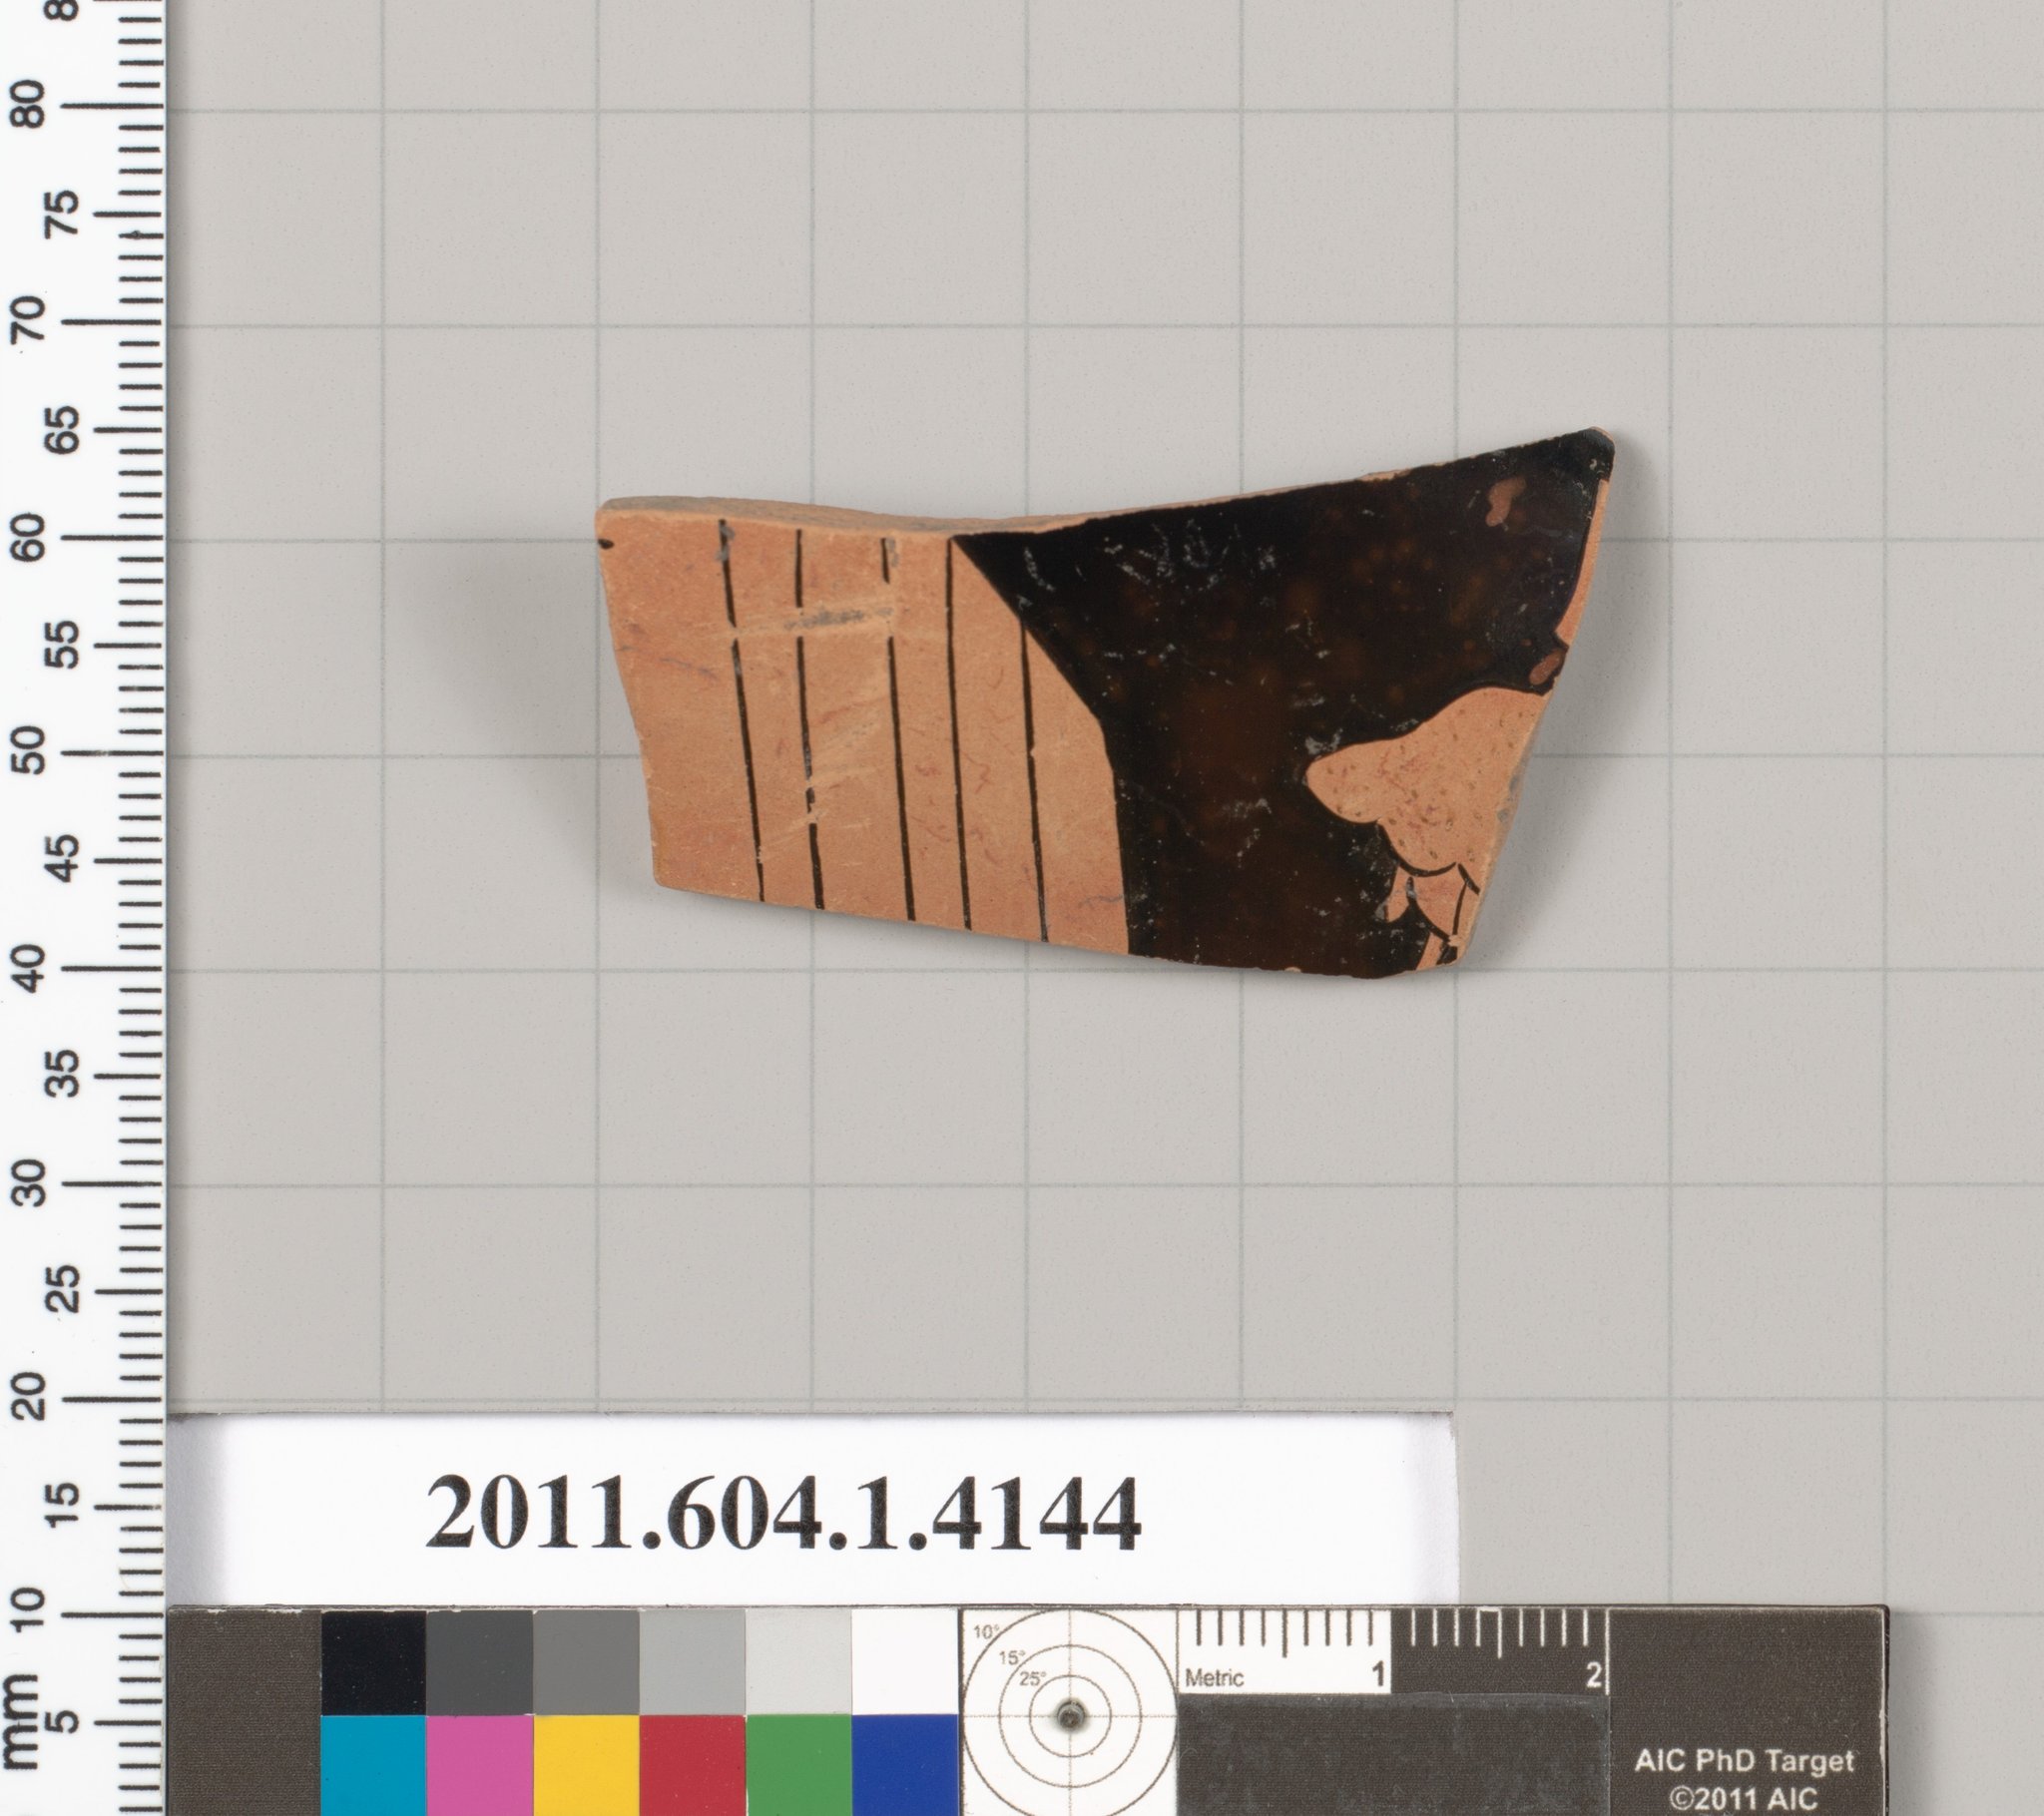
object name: kylix fragment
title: Terracotta fragment of a kylix (drinking cup)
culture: greek, attic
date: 490-470 BCE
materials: terracotta